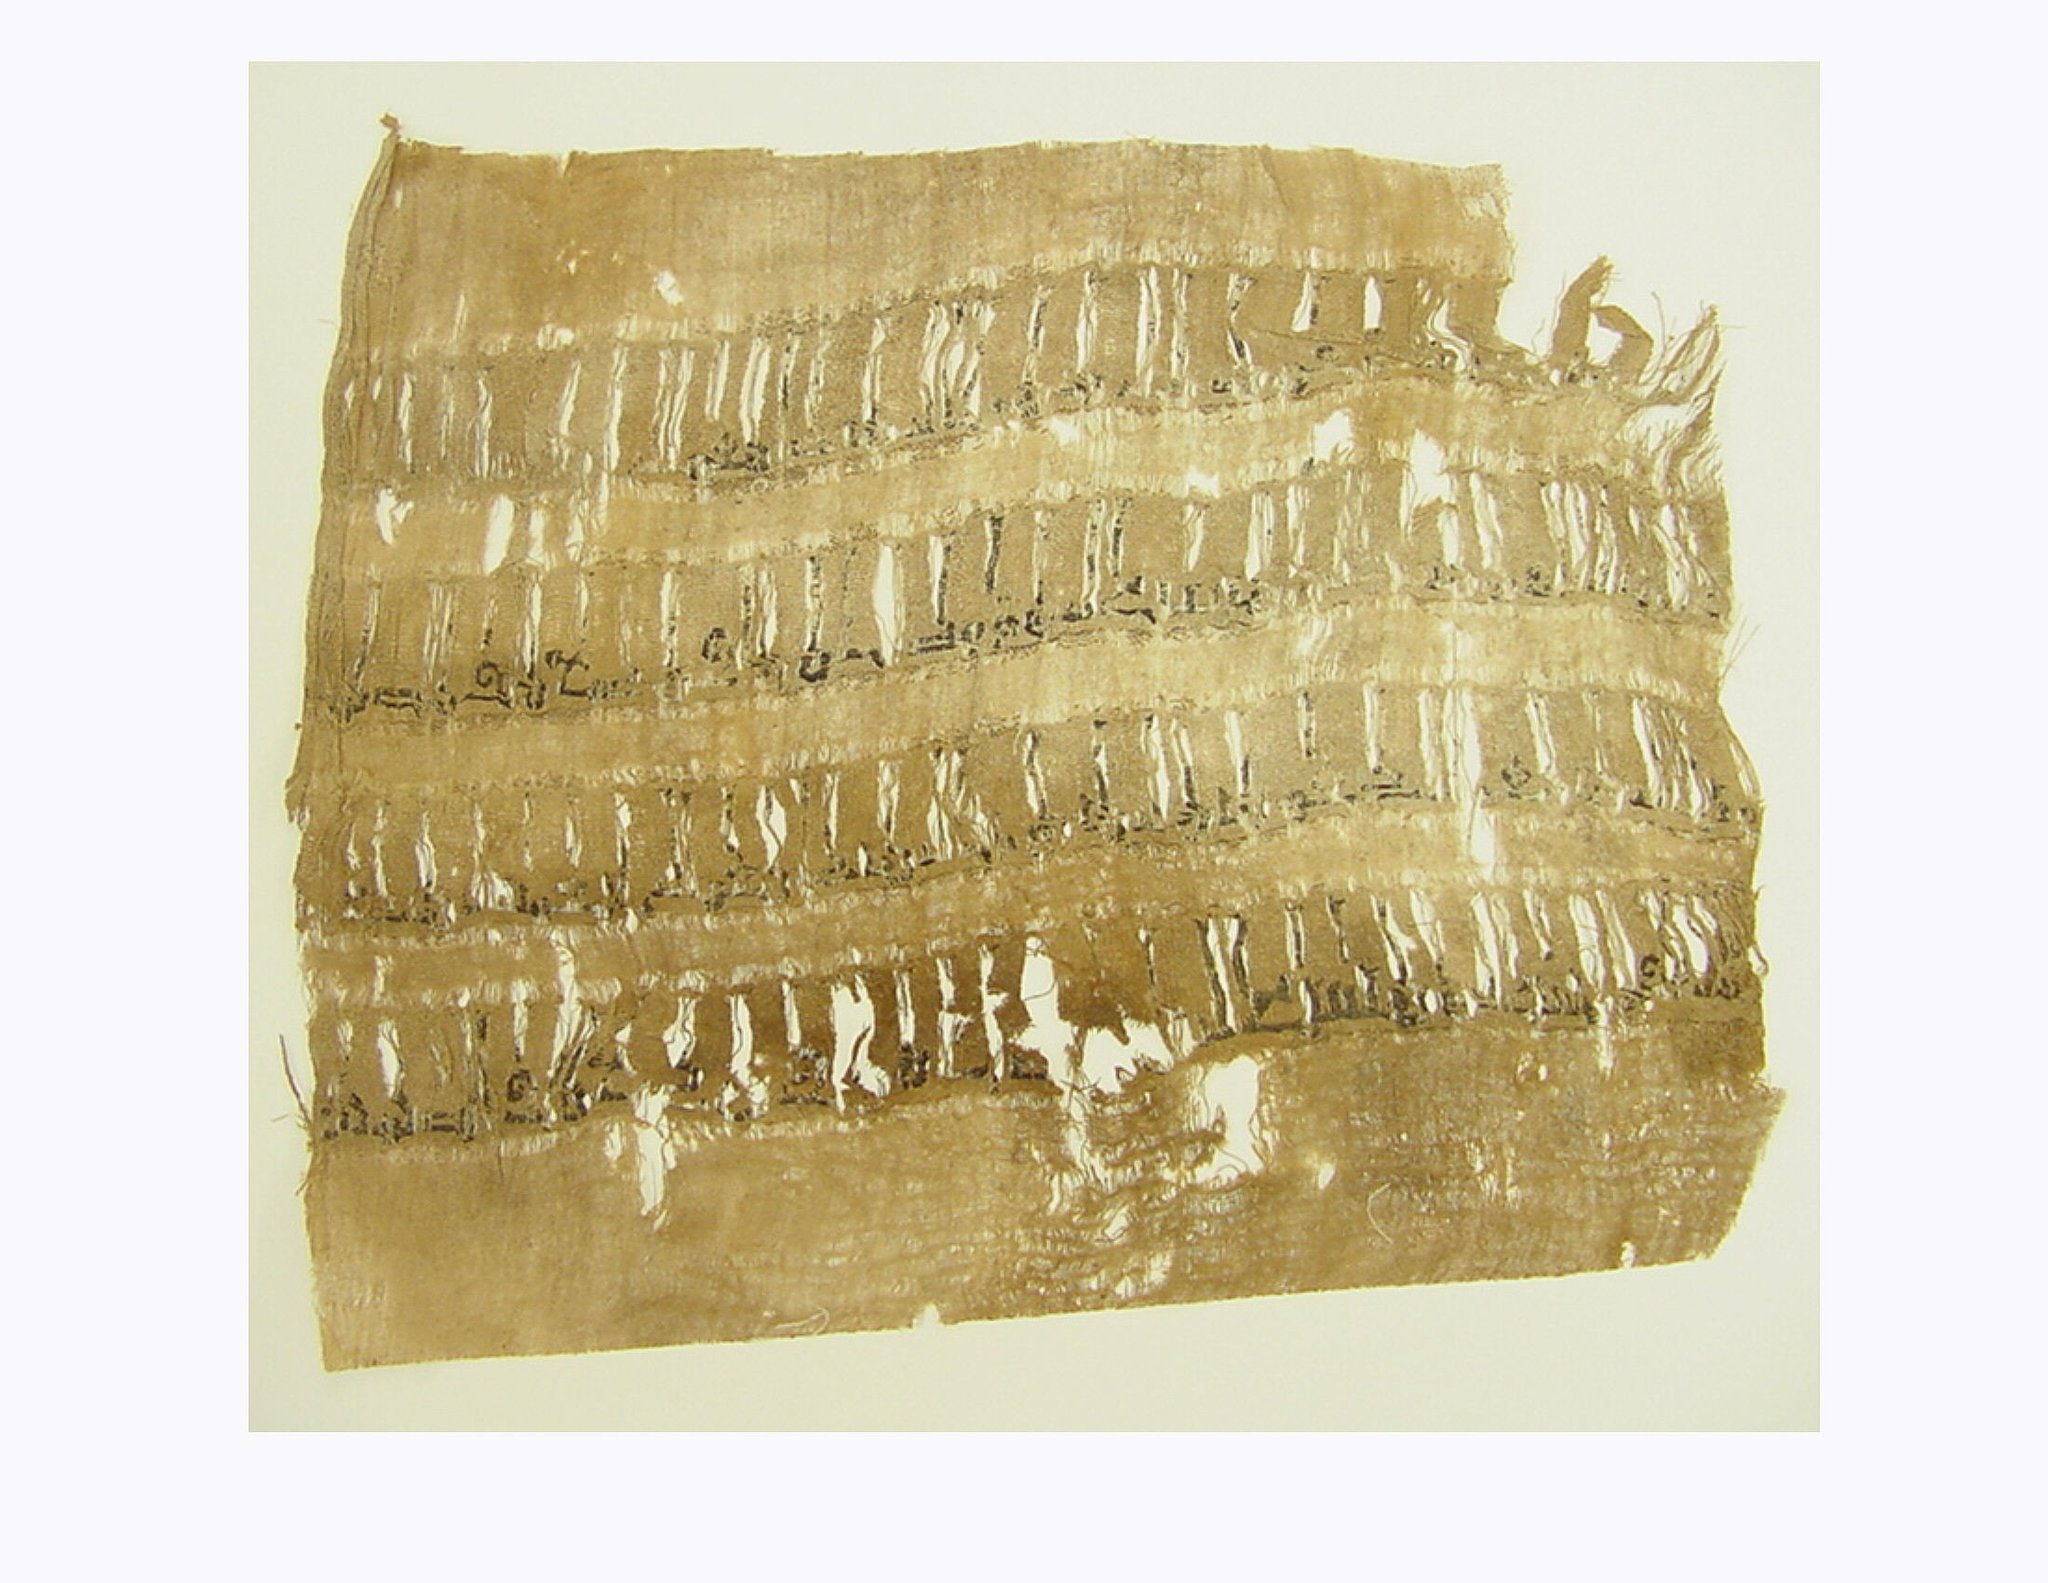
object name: textile fragment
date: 901-1000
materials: linen, silk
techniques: weave